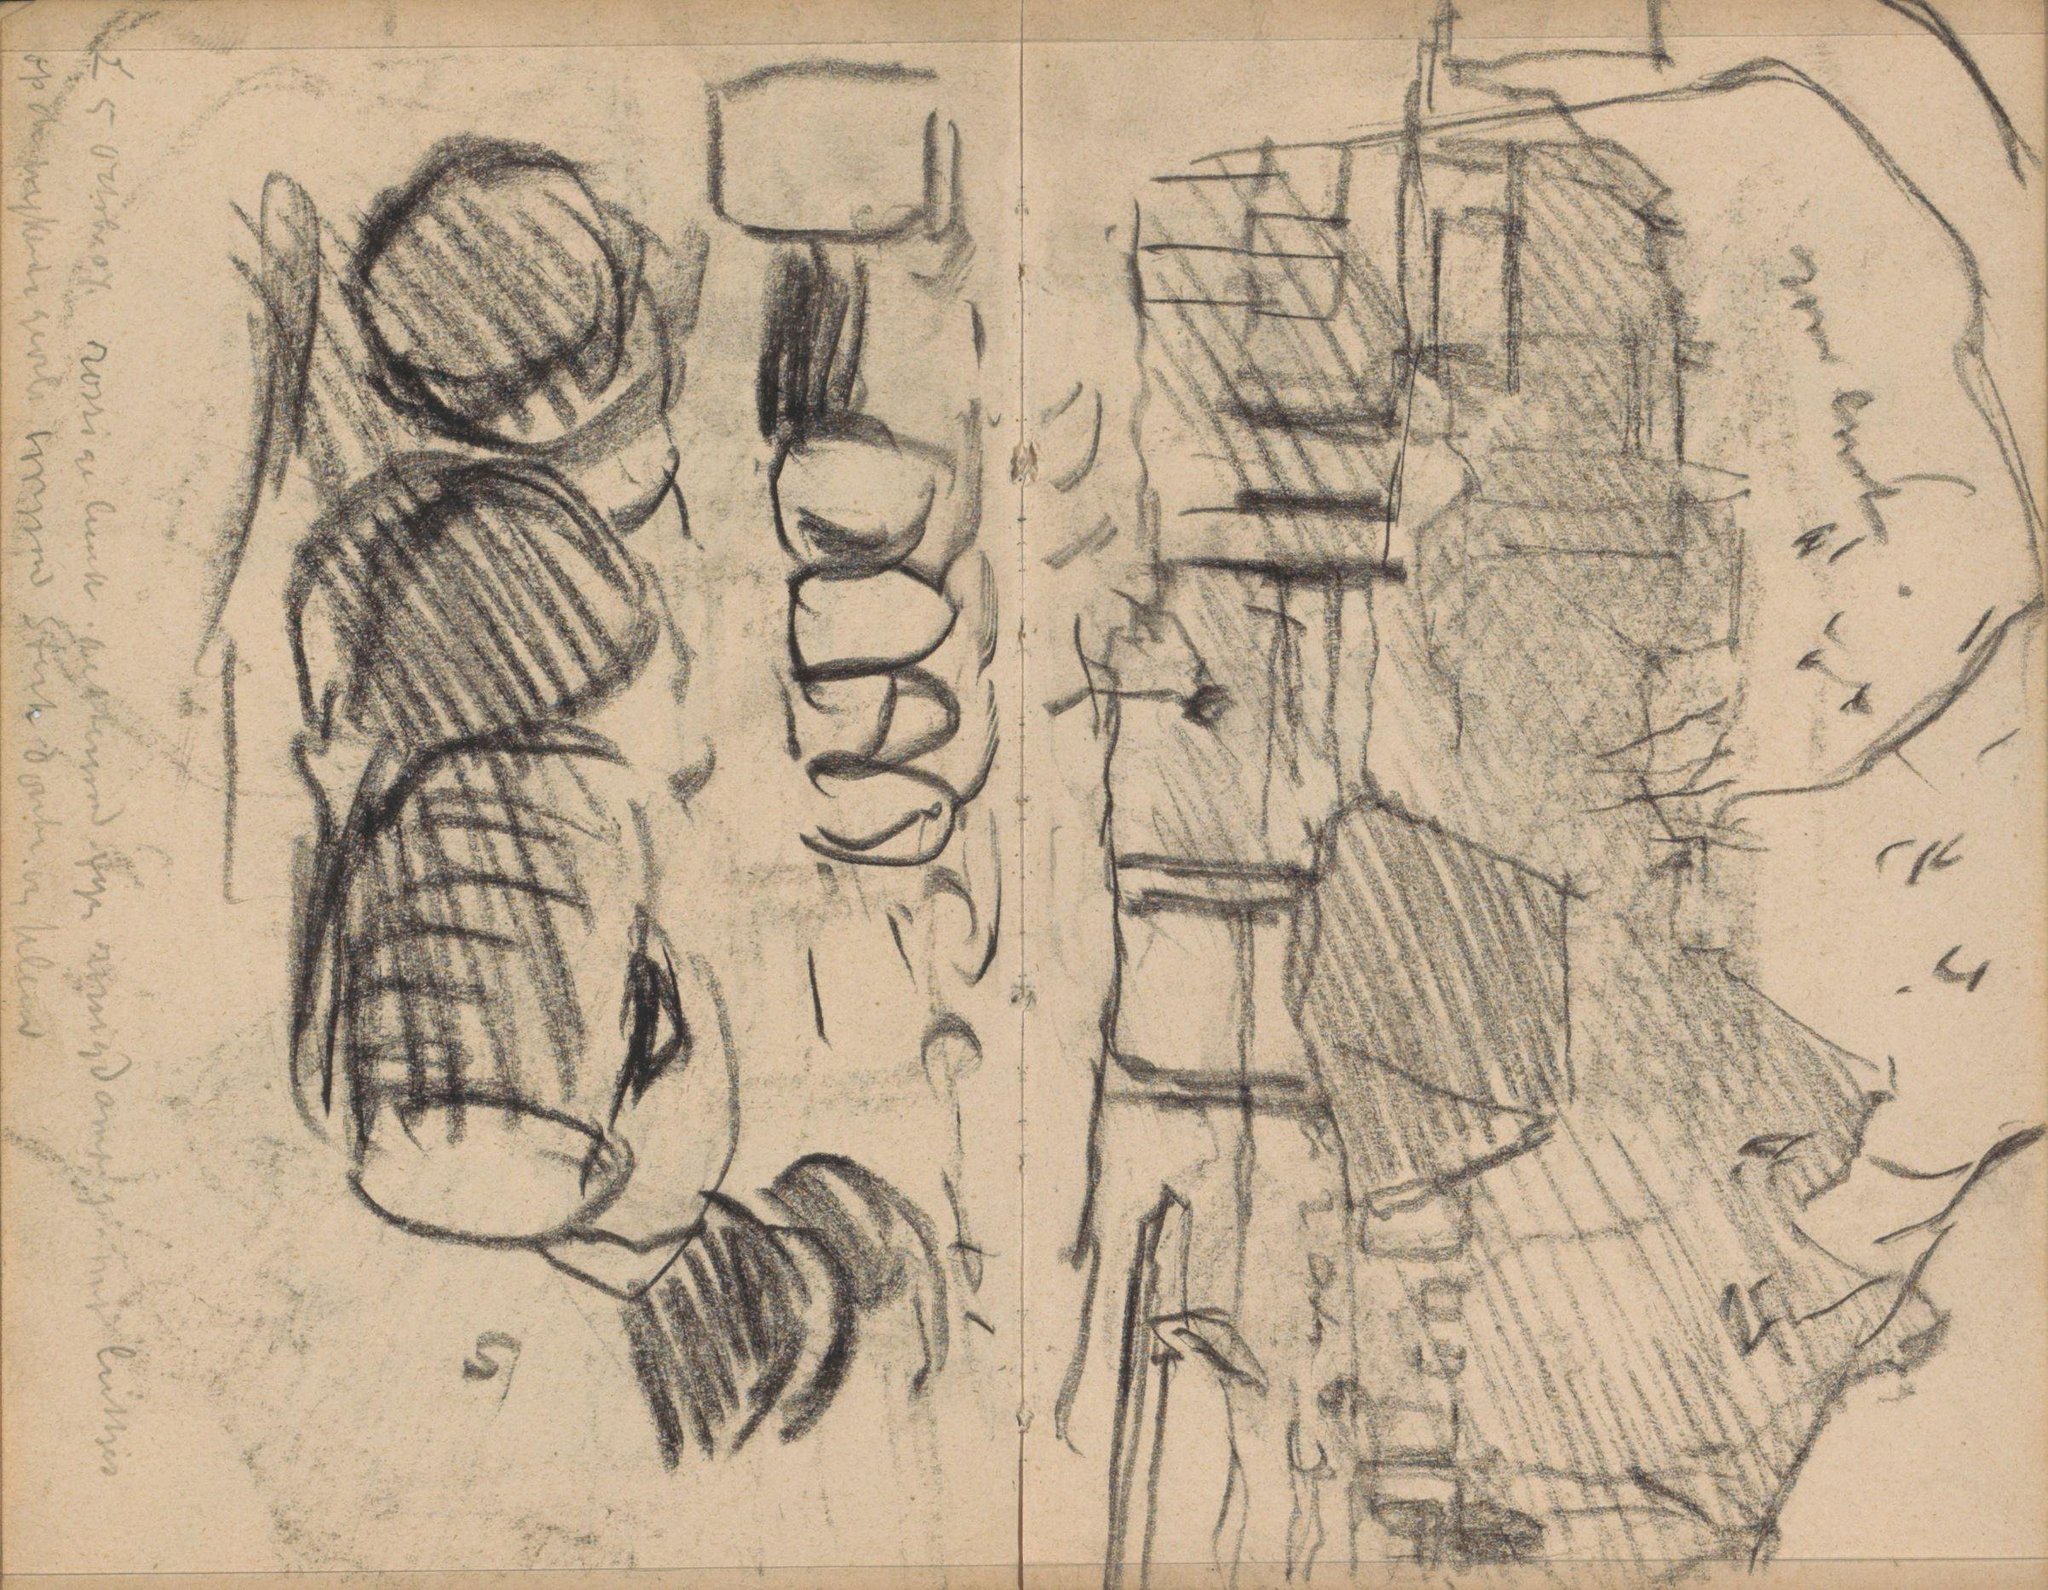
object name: sketchbook leaf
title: Gezicht op de Prinseneilandsgracht te Amsterdam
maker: george hendrik breitner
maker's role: draughtsman, painter, print maker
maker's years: 1857-1923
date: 1907-1909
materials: chalk, paper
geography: amsterdam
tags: canals, waters (in city), quay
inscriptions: annotation: ‘[...] rossige buurt. achterom[?] zijn rossig[...] met lussjes/ op de wijkende gevels [...] sterk donker van kleur’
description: Gezicht op de Prinseneilandsgracht te Amsterdam. In het midden een kraan van de teerfabriek. Vooraan teertonnen. Pagina 33 en pagina 34 uit een schetsboek met 46 bladen vervaardigd te Antwerpen, Gent en Amsterdam.